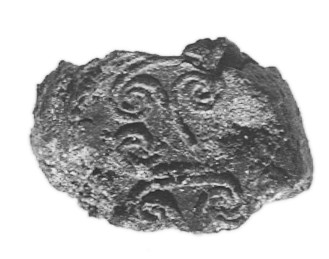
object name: sealing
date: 2030-1640 BCE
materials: clay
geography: egypt